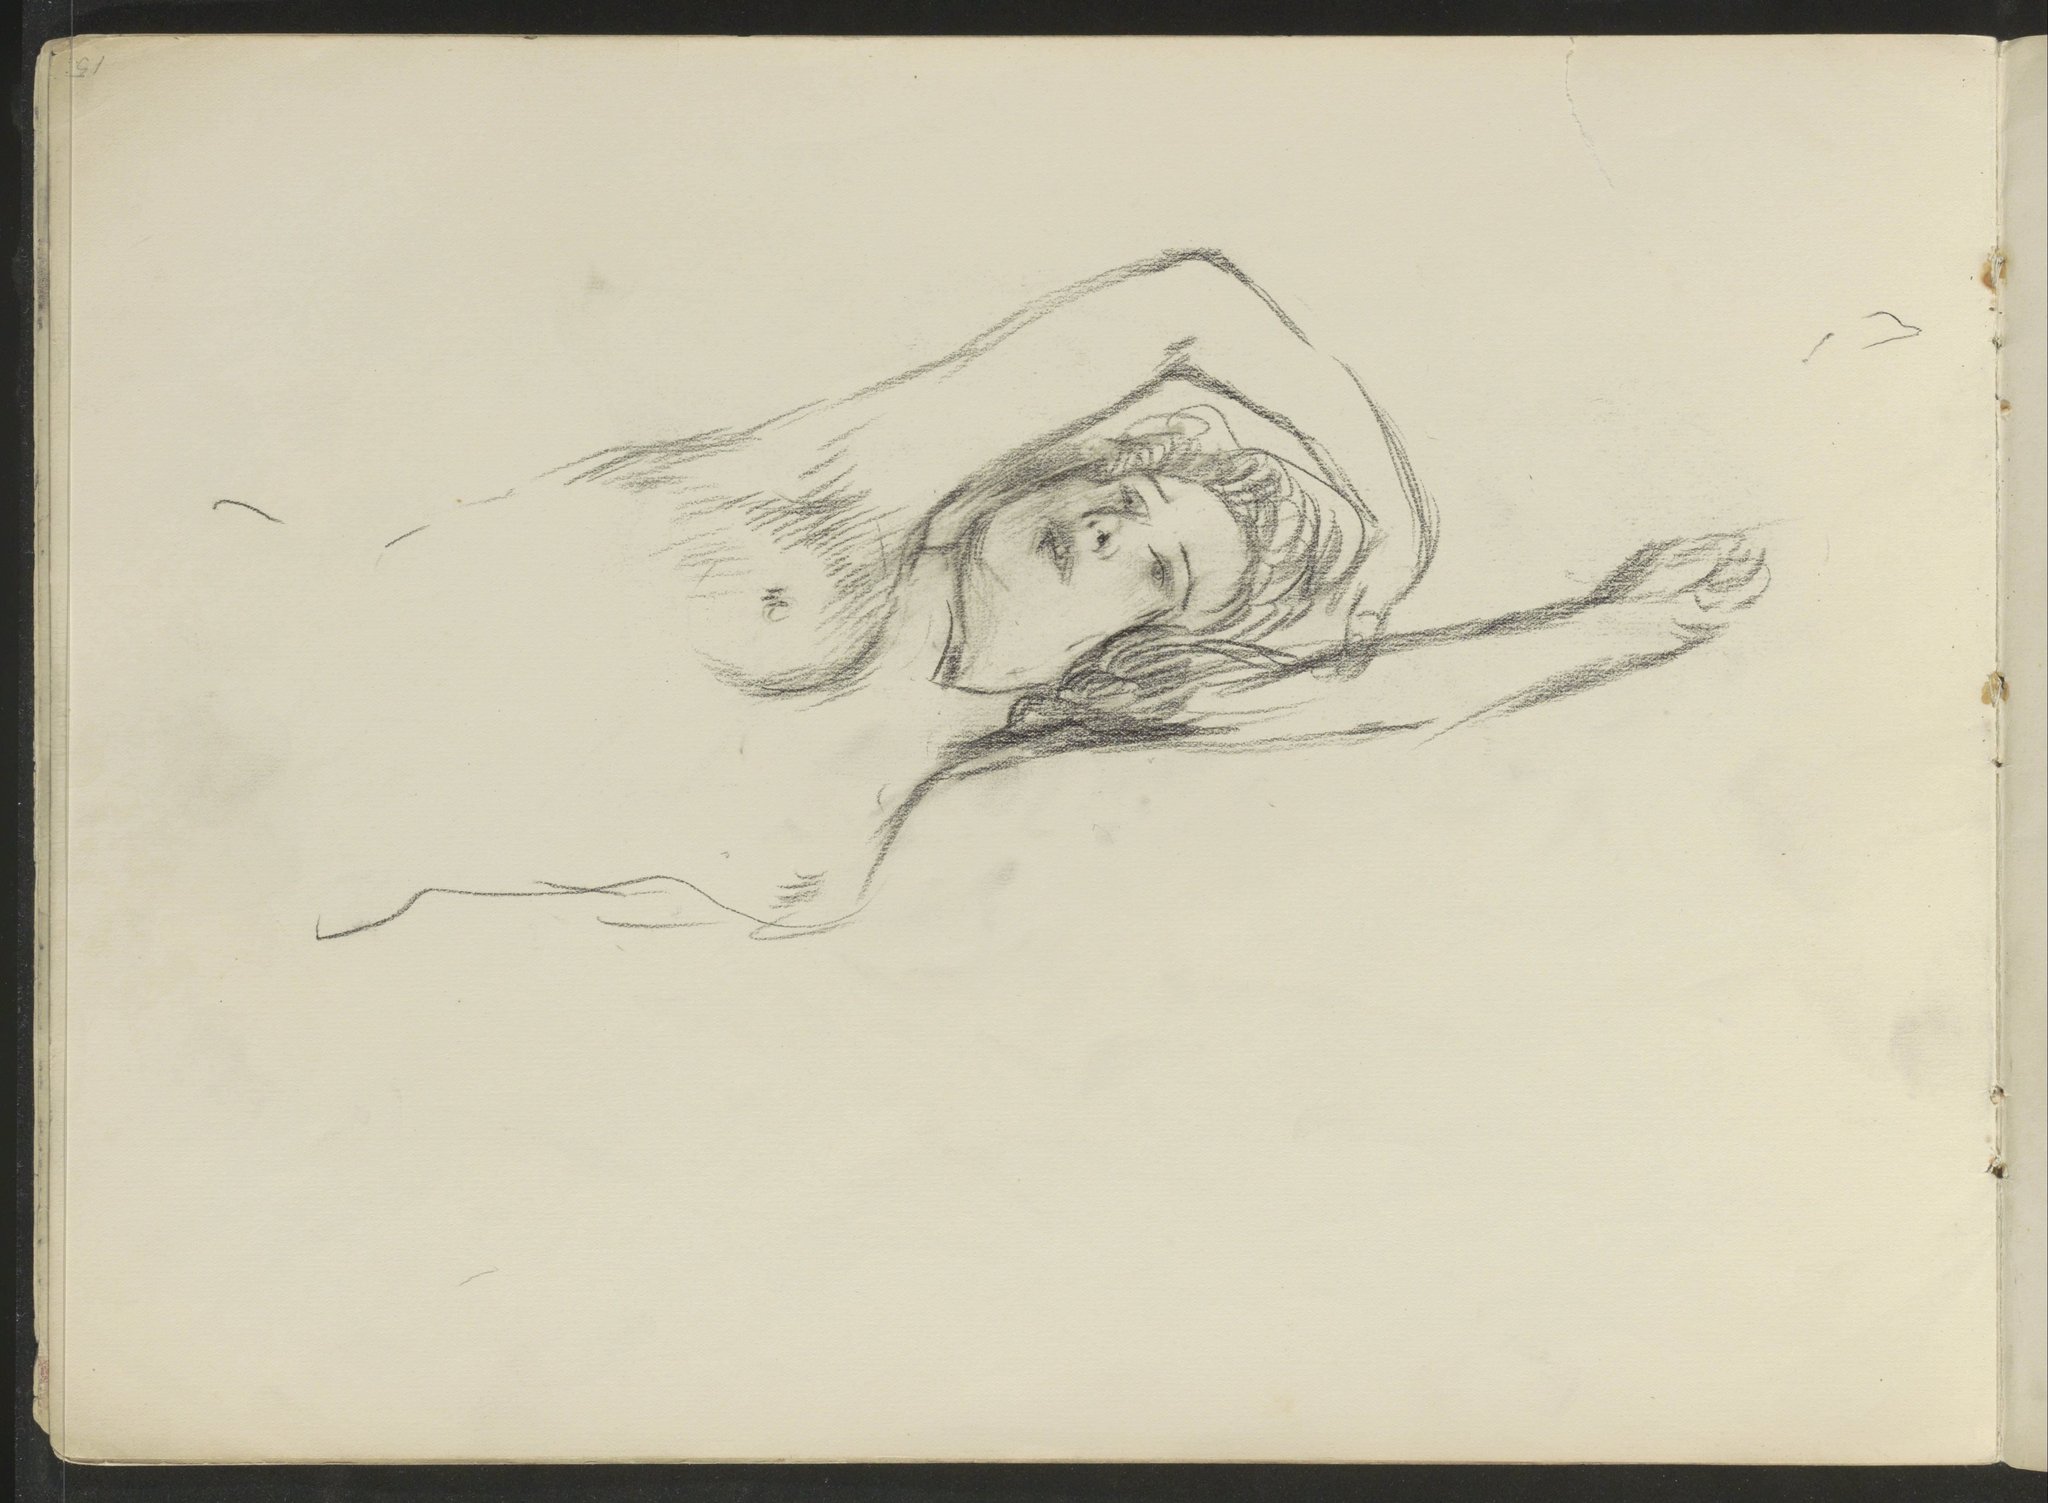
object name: sketchbook leaf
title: Reclining Female Nude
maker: isaac israels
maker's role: draughtsman, painter, print maker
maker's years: 1865-1934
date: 1886-1934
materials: chalk, paper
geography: amsterdam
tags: the (nude) human figure; 'corpo humano' (ripa) - aa - female human figure (+ lying)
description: Blad 9 verso uit schetsboek LXVII met 11 bladen.